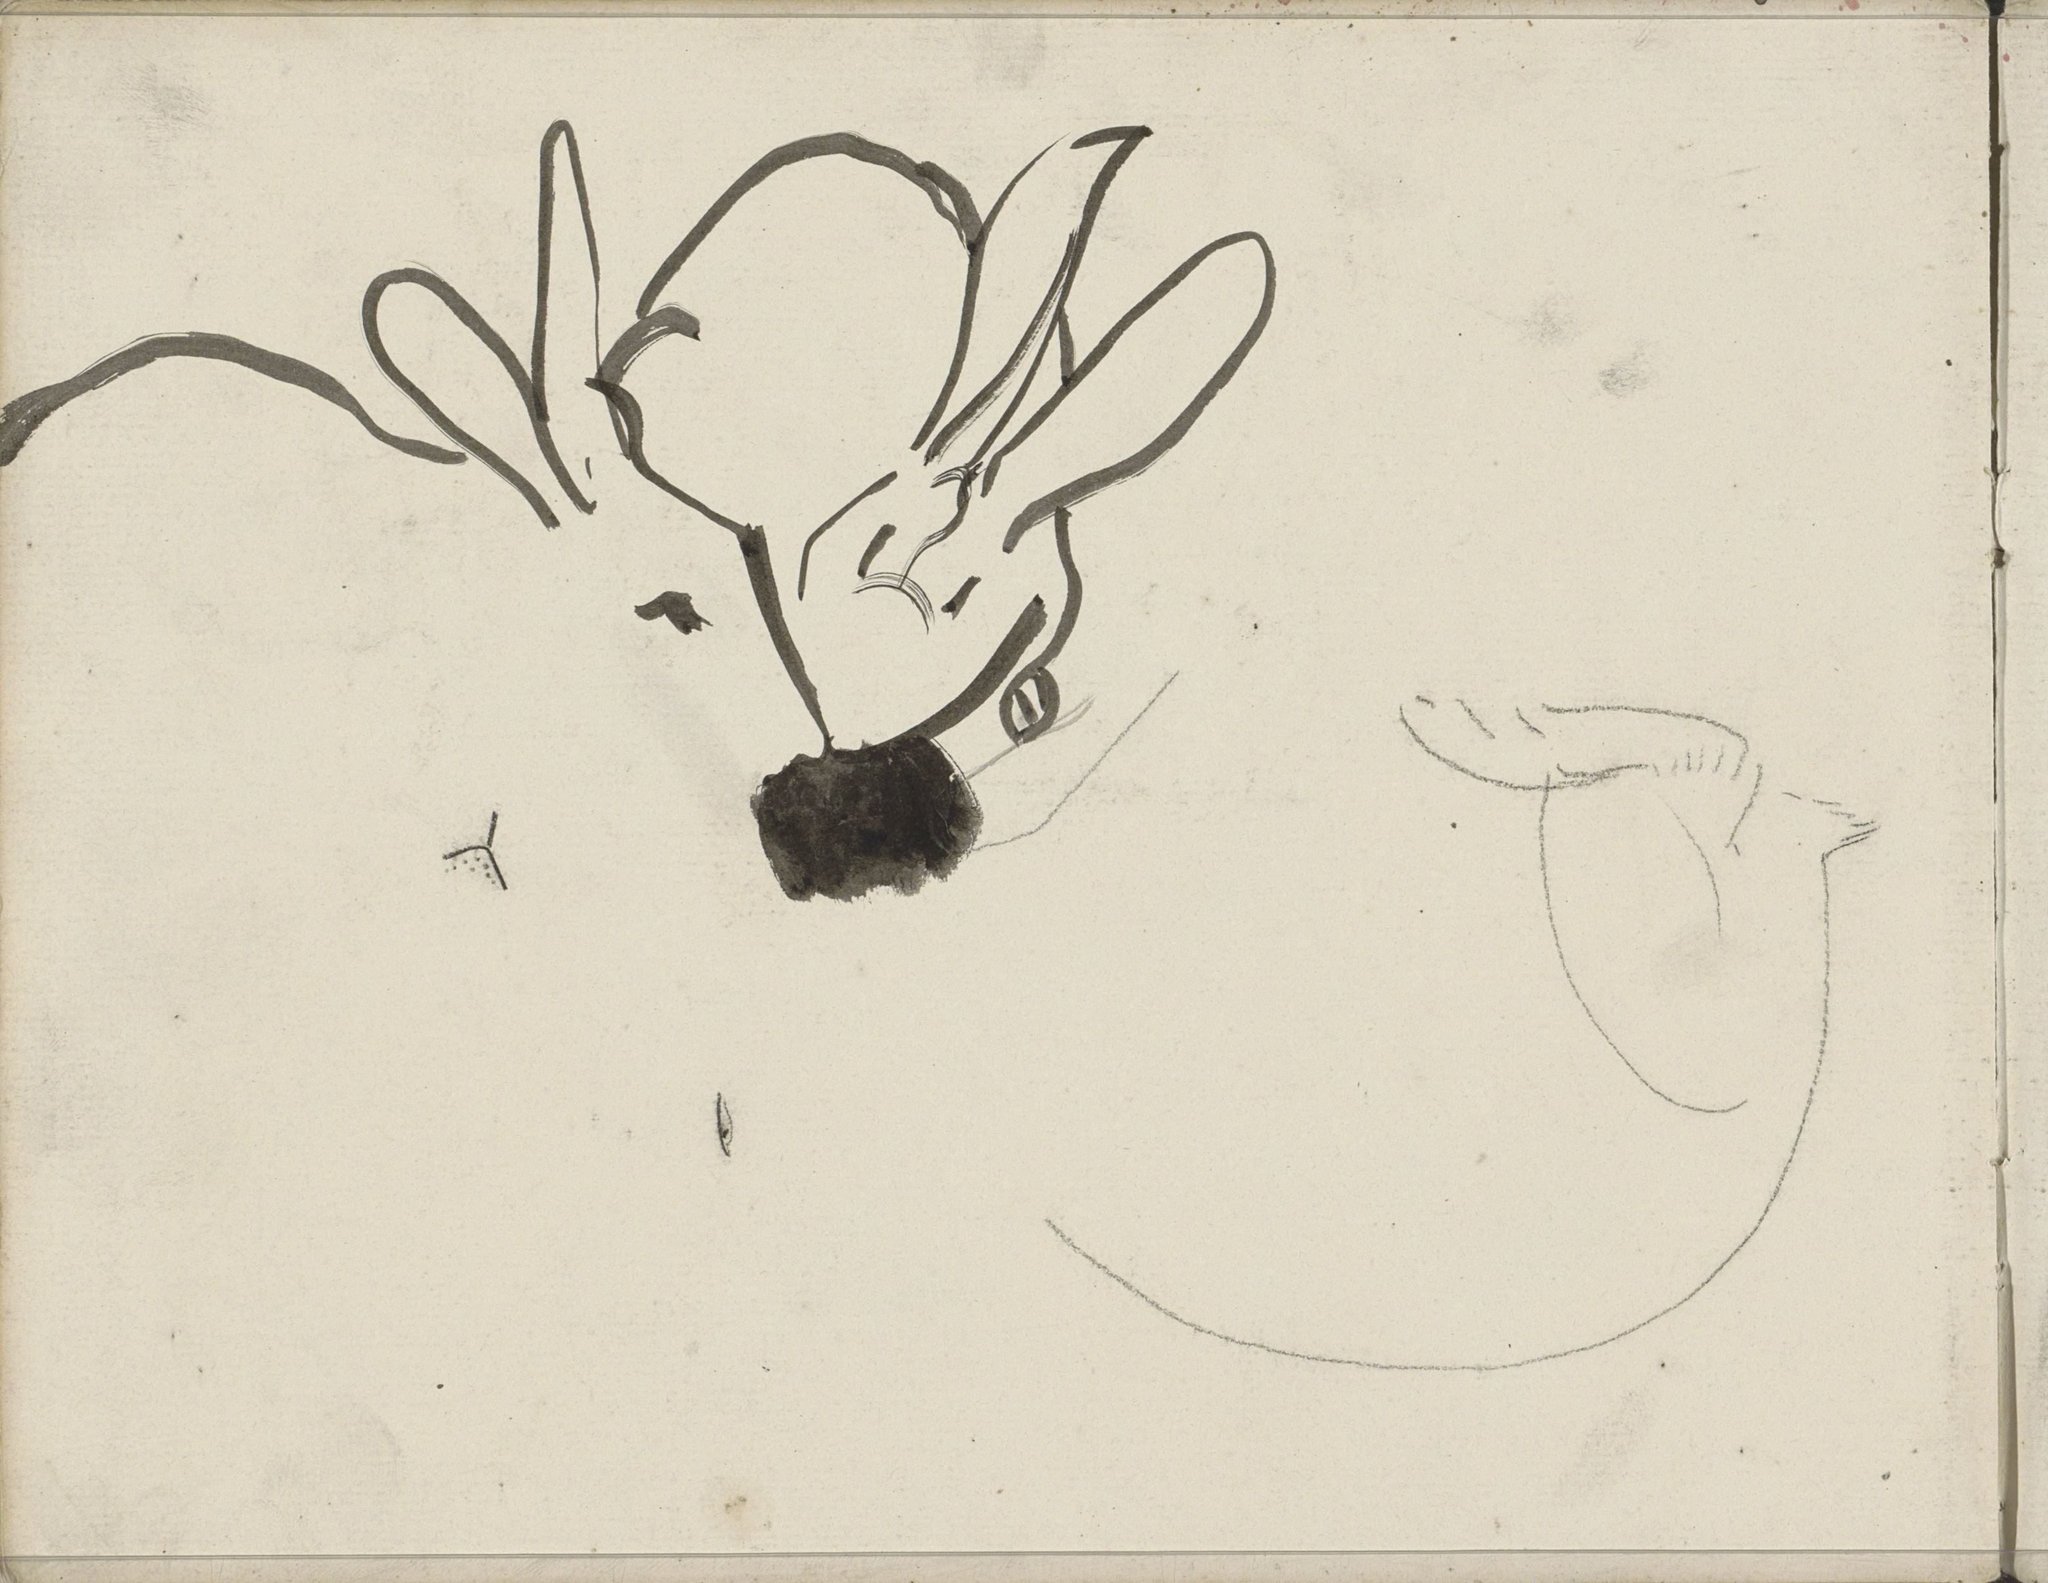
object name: sketchbook leaf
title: Konijn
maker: carel adolph lion cachet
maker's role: draughtsman, print maker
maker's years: 1864-1945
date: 1896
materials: ink, paper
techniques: brush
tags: rodents: rabbit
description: Blad 42 verso uit een schetsboek met 44 bladen.